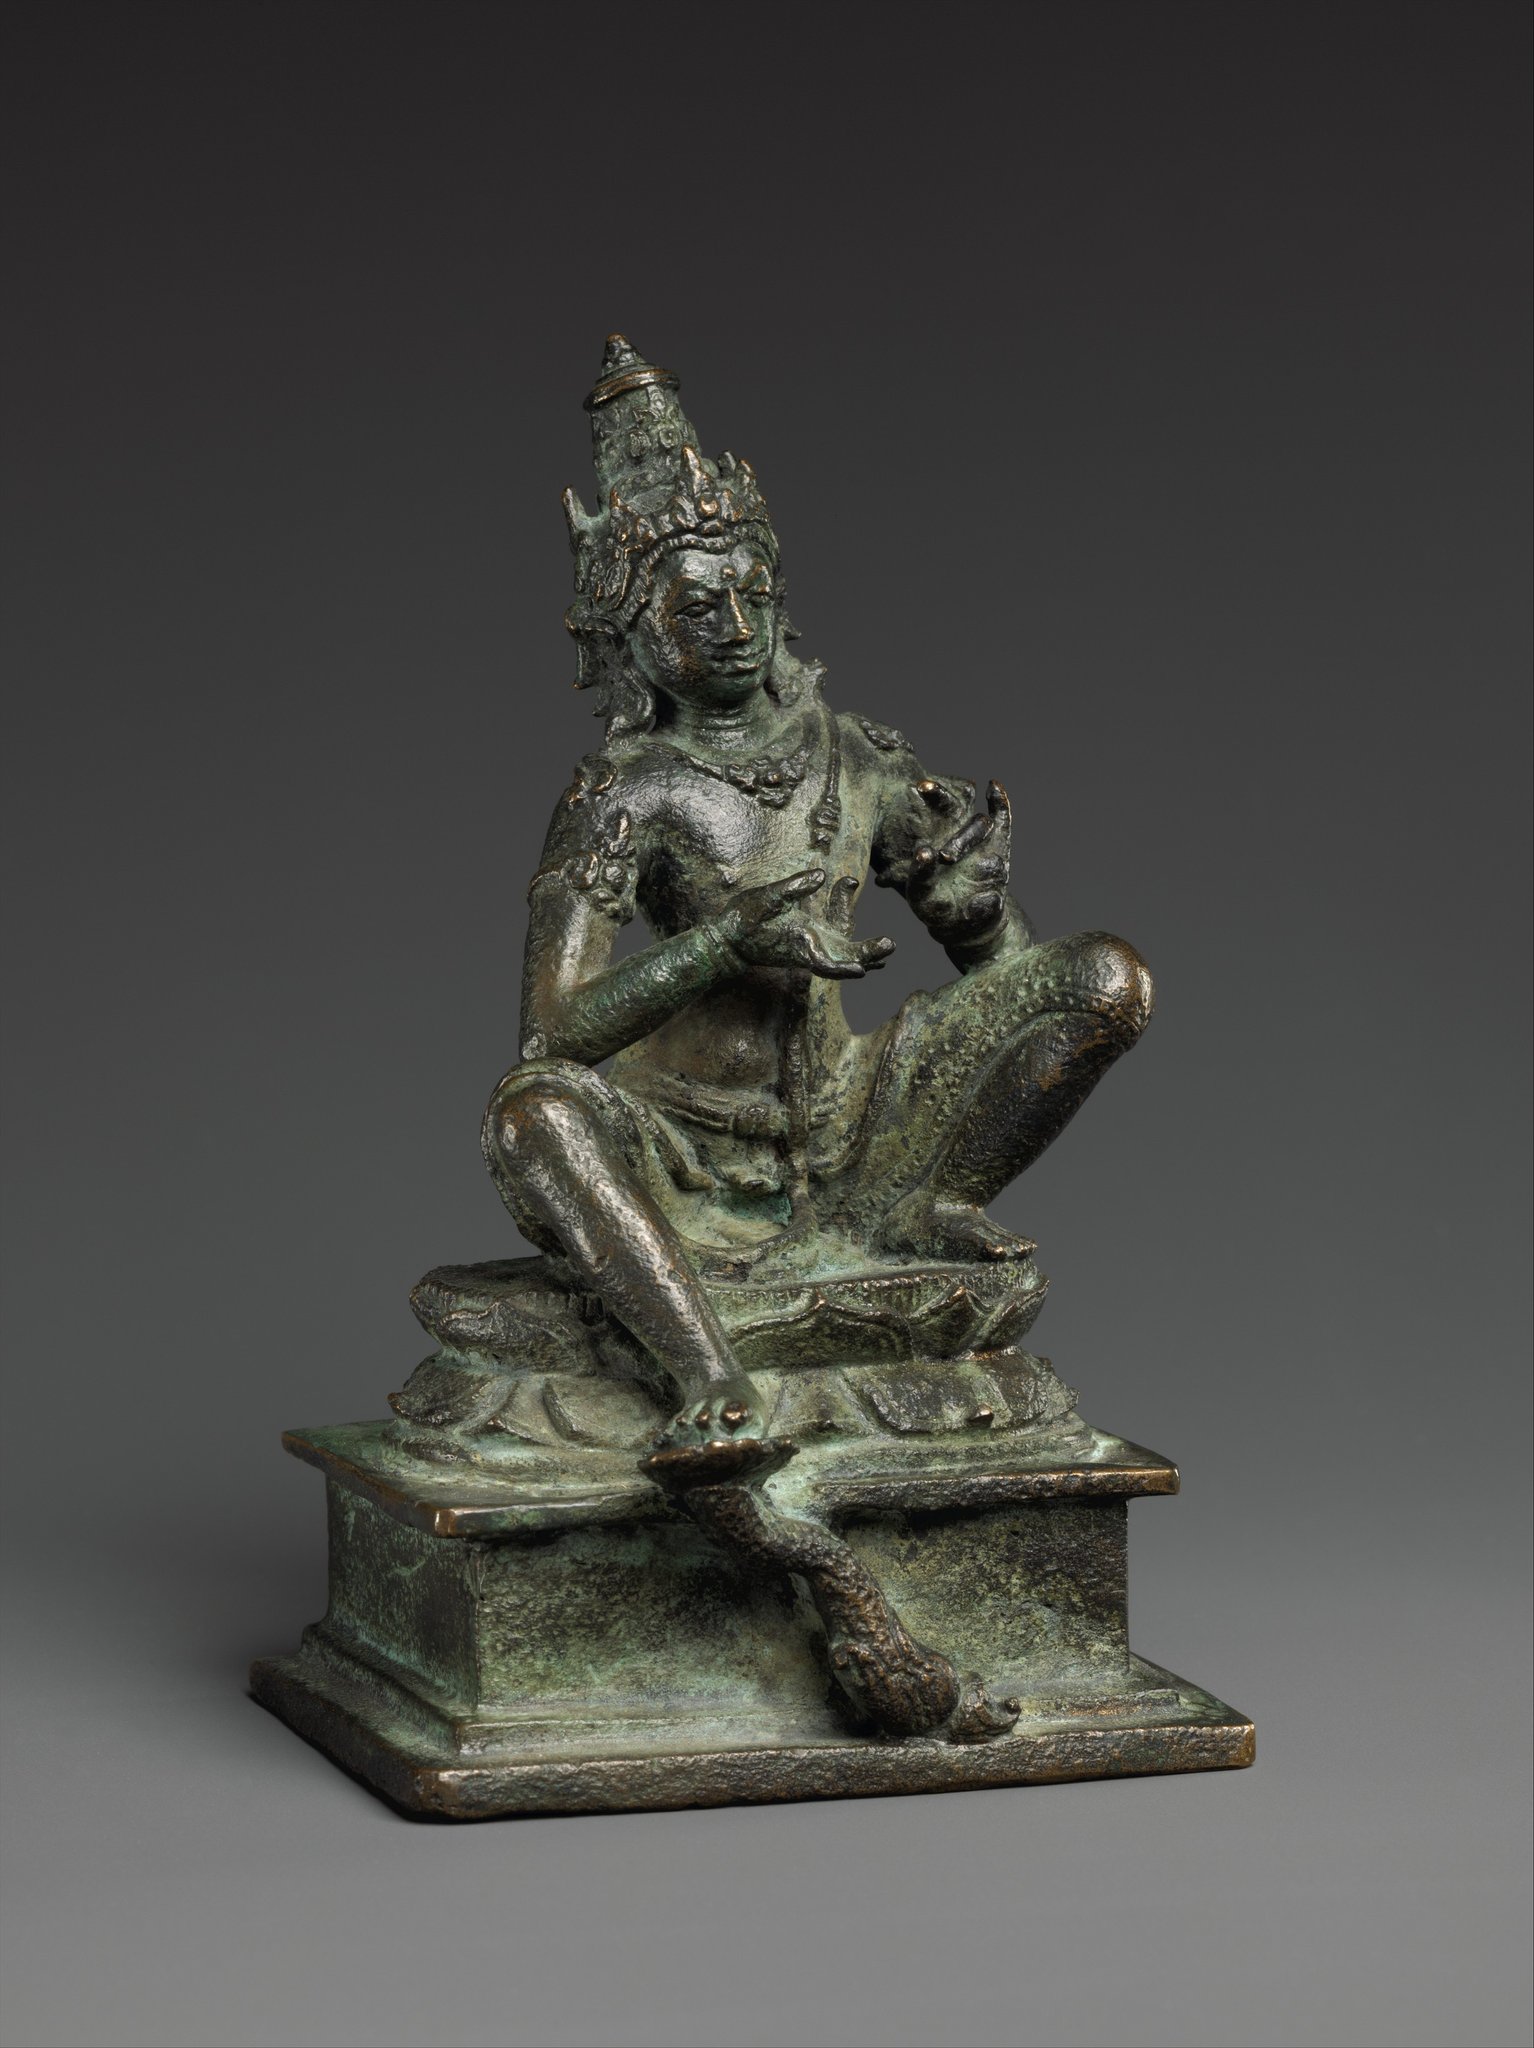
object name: figurine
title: Seated Bodhisattva Vajrapani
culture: indonesian, javanese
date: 801-900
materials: bronze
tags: buddhism,bodhisattvas,vajrapani